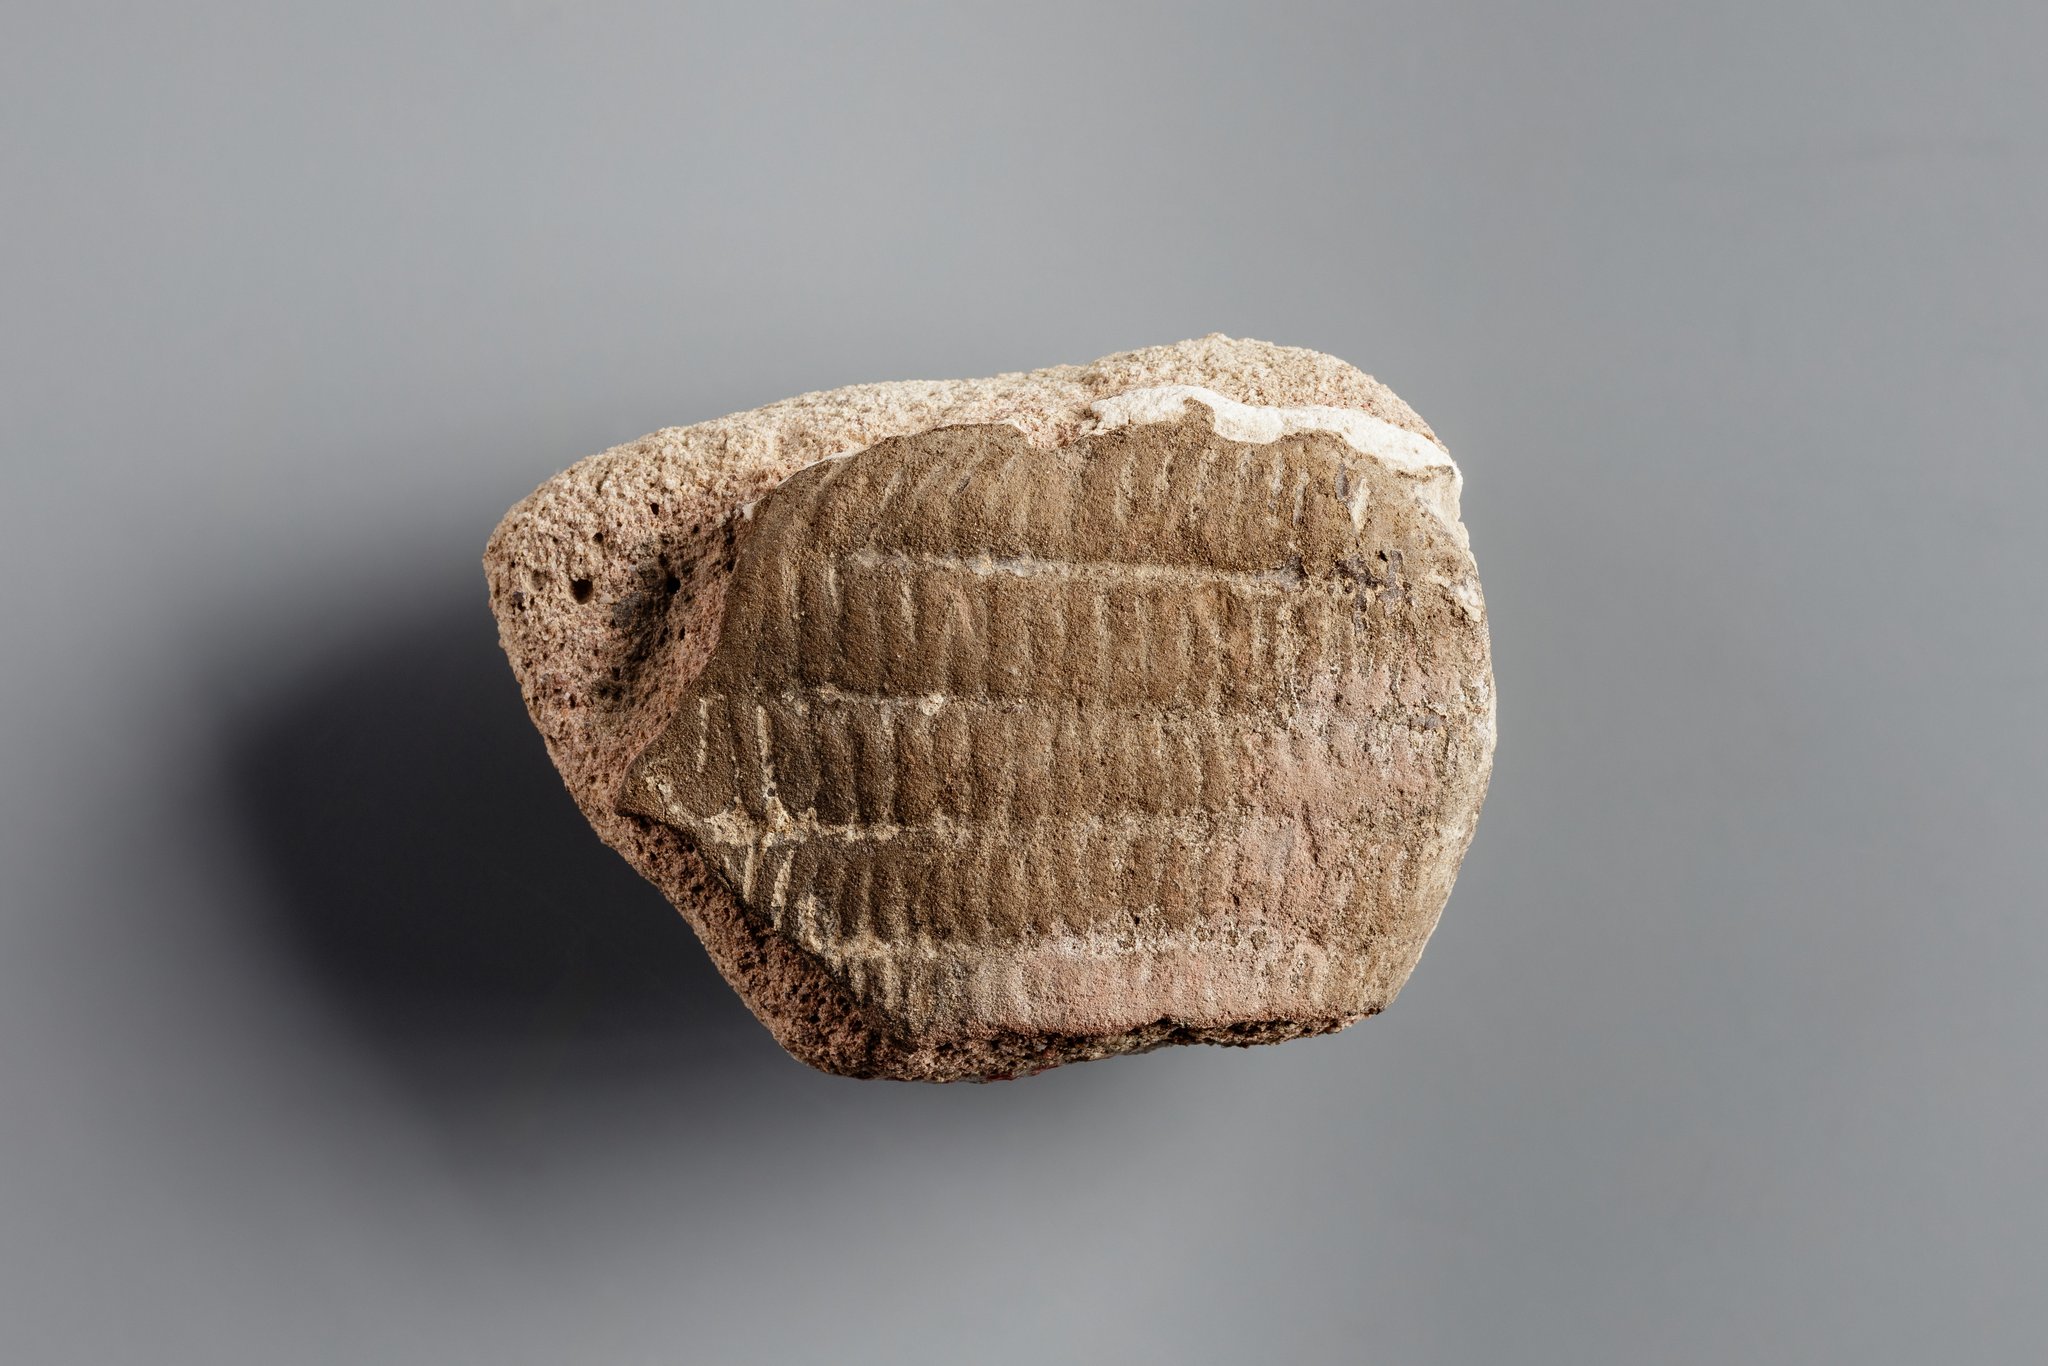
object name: tile inlay, palace of ramesses ii, foreigner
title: Tile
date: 1279-1213 BCE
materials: faience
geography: egypt